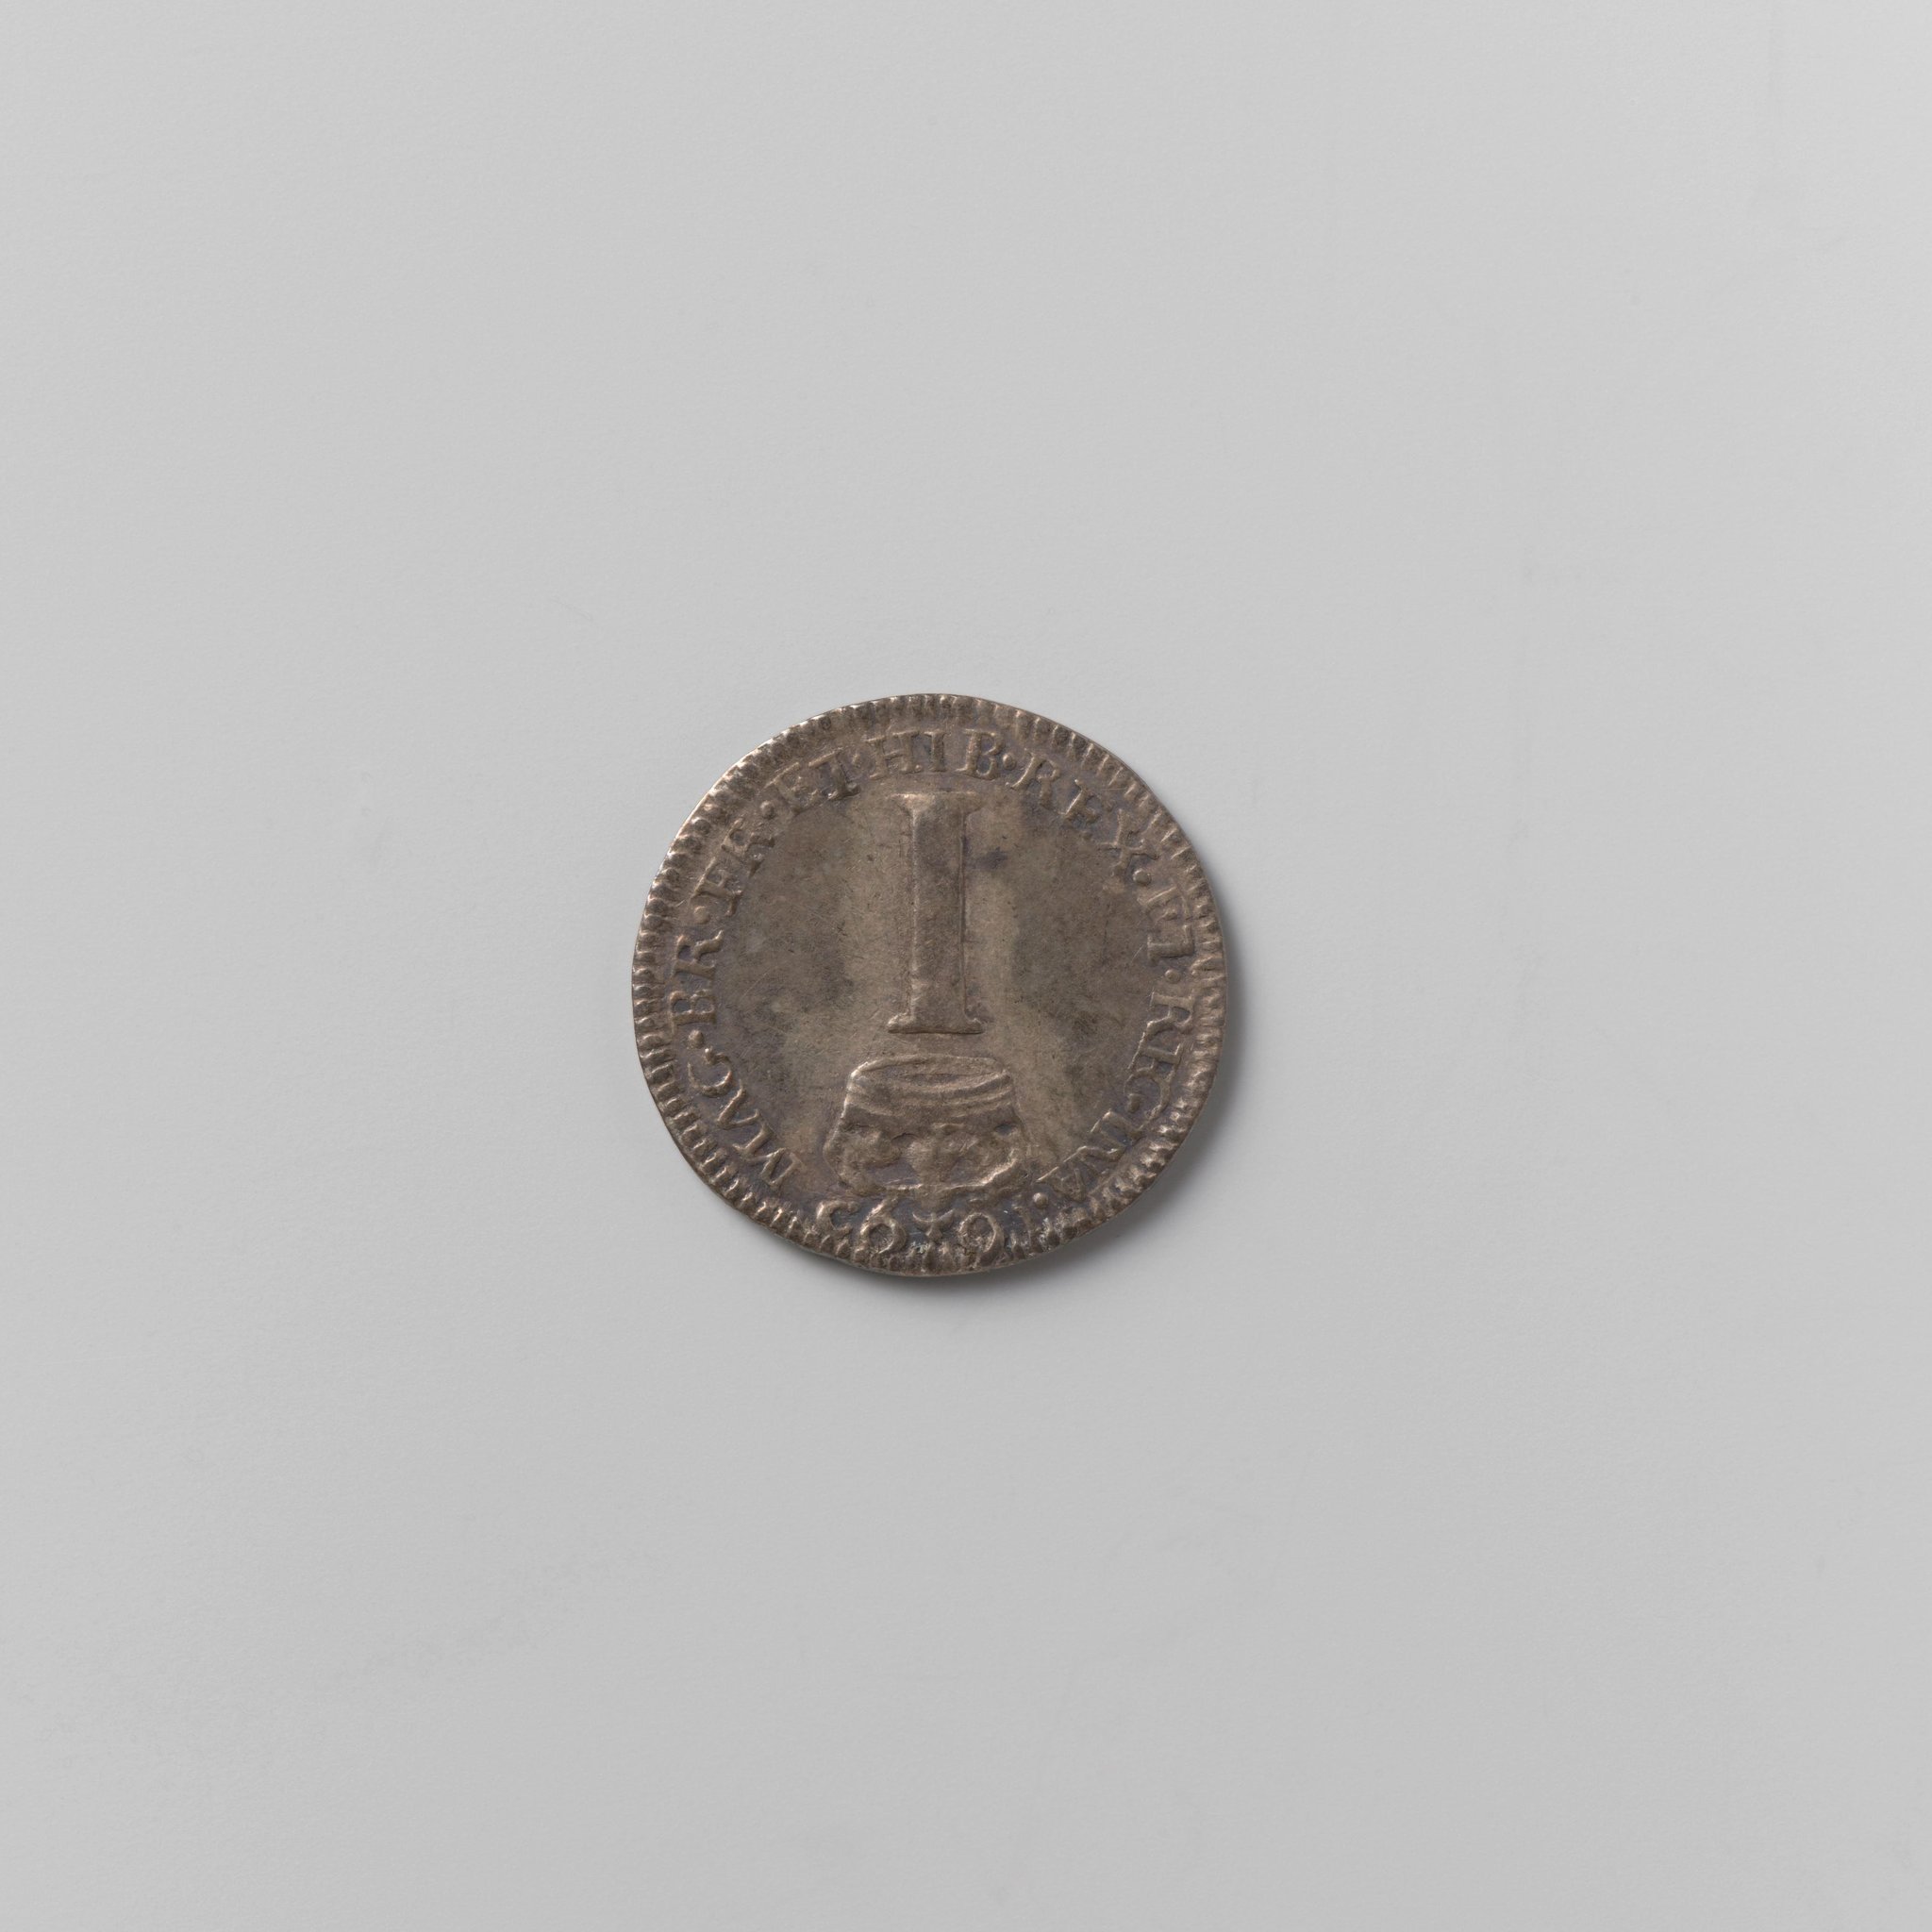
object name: coin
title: Engeland, Willem en Mary, penny, 1693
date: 1693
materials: silver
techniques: striking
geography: london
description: Zilveren munt. Voorzijde: borstbeelden van de koning en de koningin naar rechts. Keerzijde: gekroond cijfer een. Jaartal bovenaan rondom kroon. Maundy money.